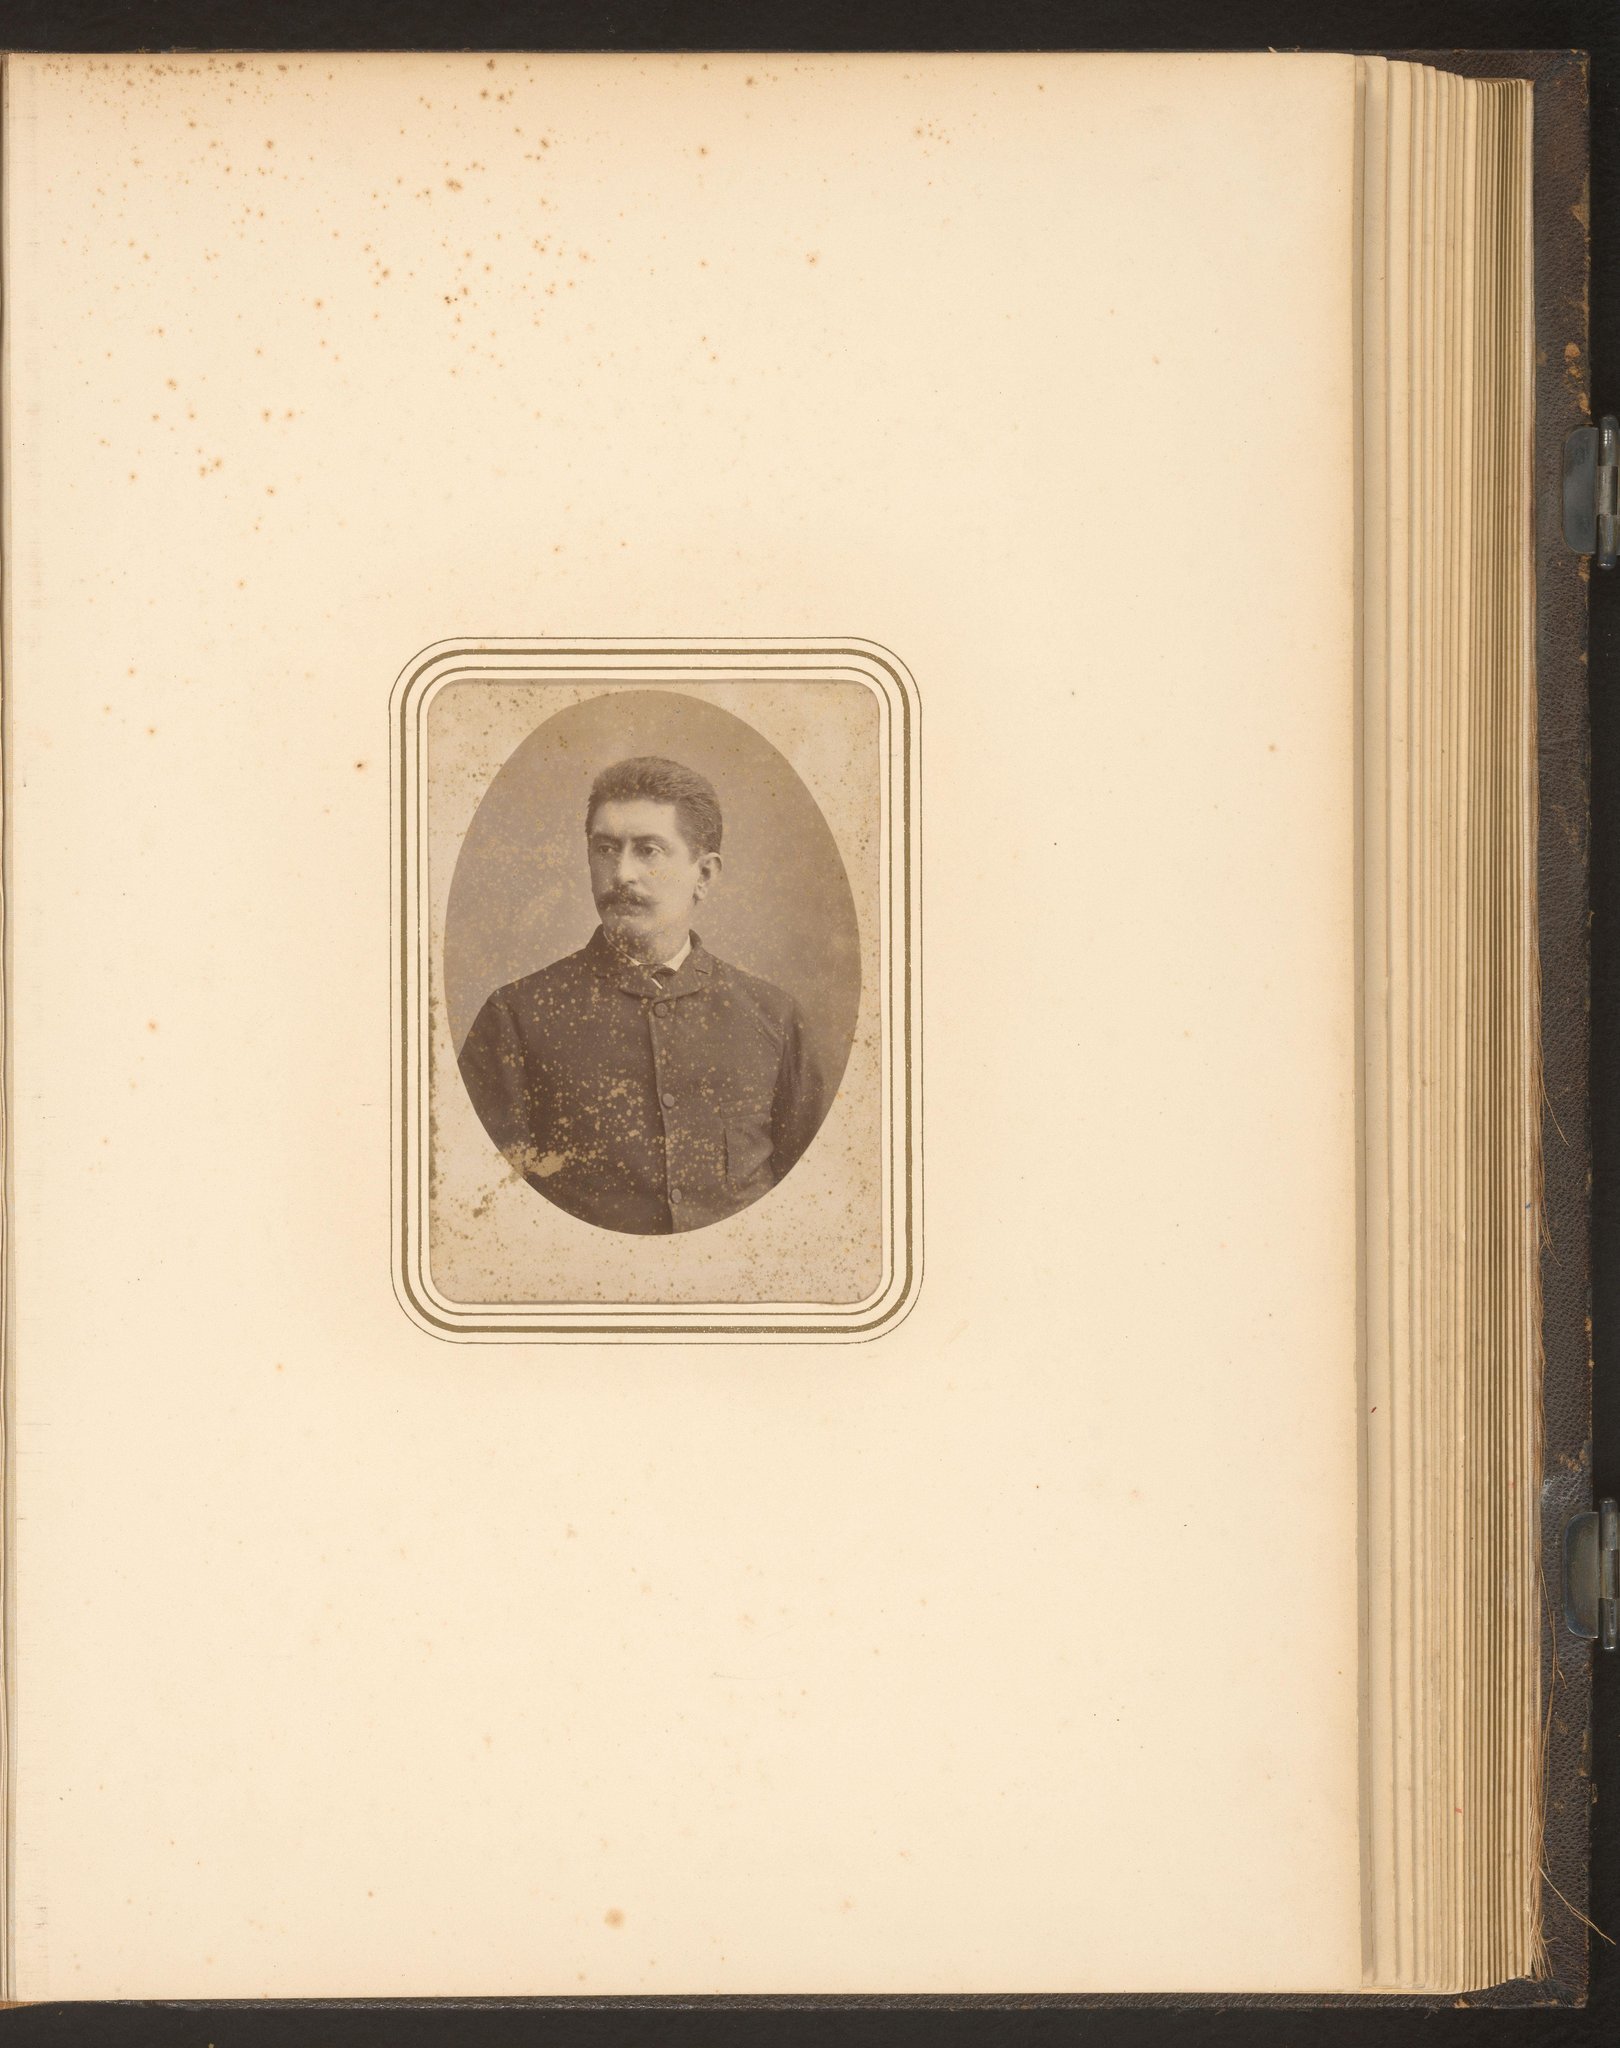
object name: cabinet photograph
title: Portret van onbekende man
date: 1882-1887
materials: cardboard, photographic support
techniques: albumen print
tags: historical persons not known by name, sumatra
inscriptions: name: ‘G.R. Lambert & Co. Photographers by appointment to H.M. the King of Siam and to H.H. the Maharajah of Johore’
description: Portret van een onbekende man. Ingestoken foto in het herinneringsalbum aangeboden door de Tabak Maatschappij Arendsburg aan hoofdadministrateur M.J. Tiele bij zijn terugkeer naar Nederland in 1887.